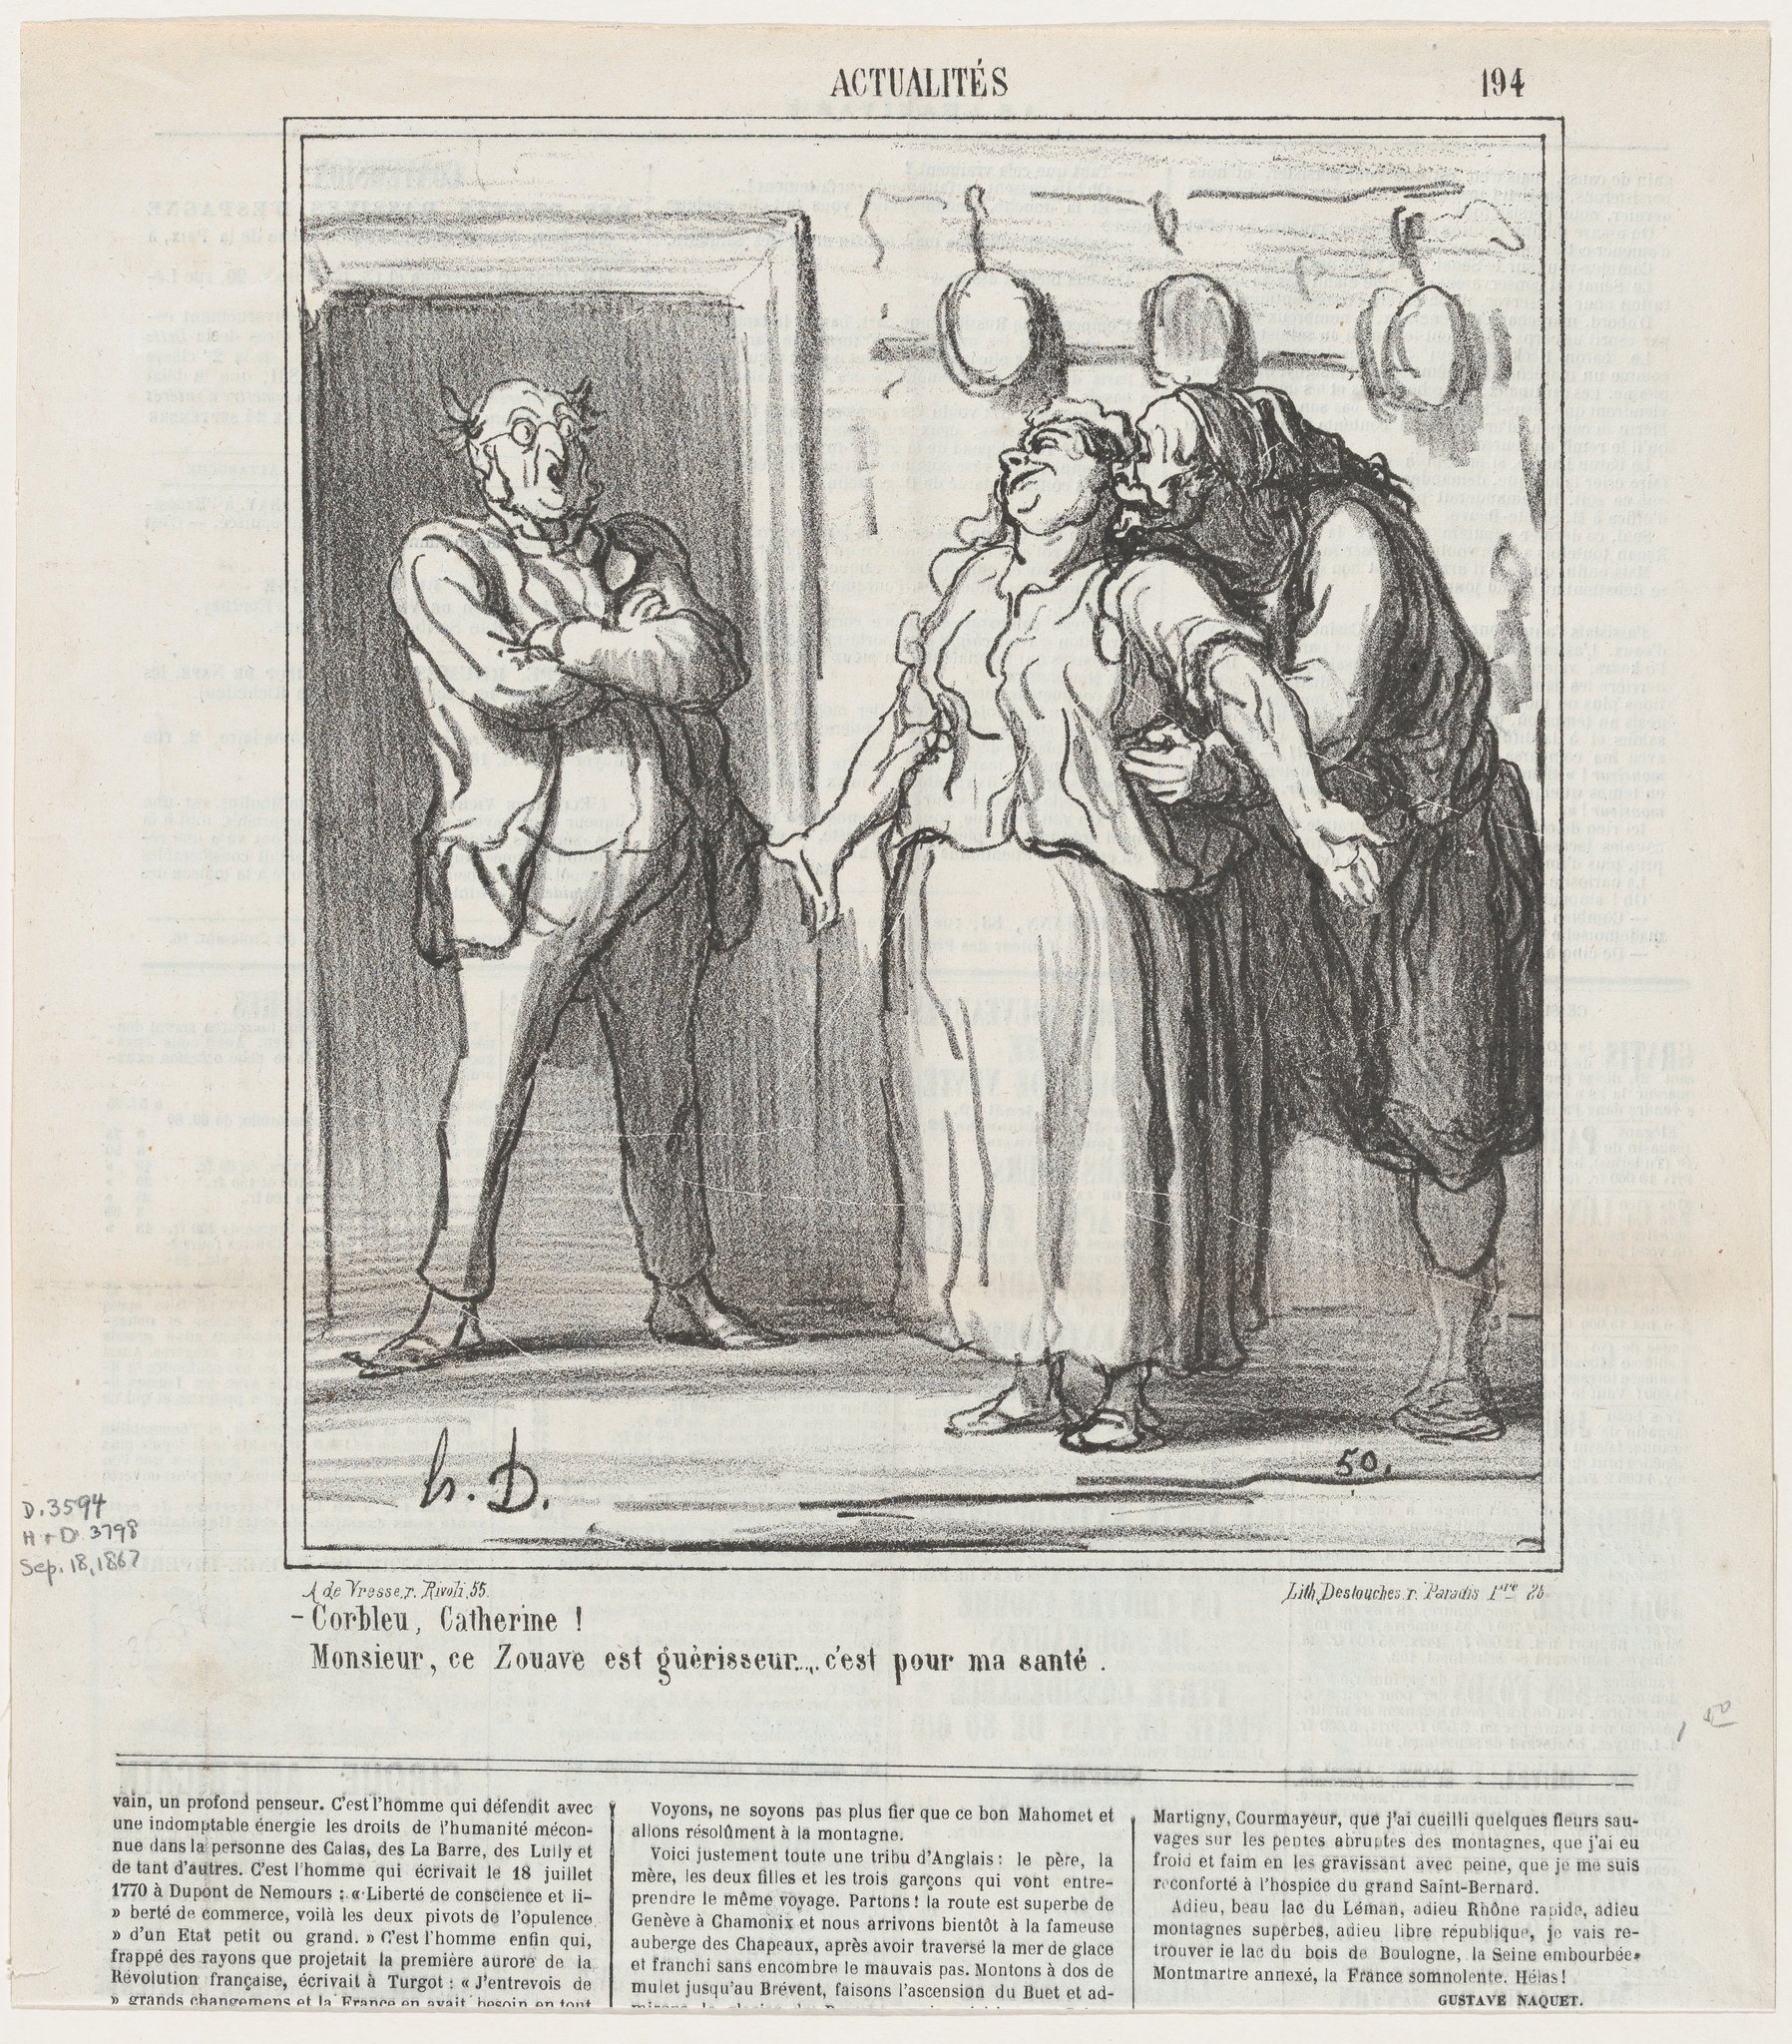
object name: print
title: –By God, Catherine.... –Monsieur, this Zouave is a healer... it's just for my health!, from 'News of the day,' published in Le Charivari, September 18, 1867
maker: honoré daumier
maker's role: artist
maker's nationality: french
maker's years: 1808-1879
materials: paper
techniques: lithograph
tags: men,women